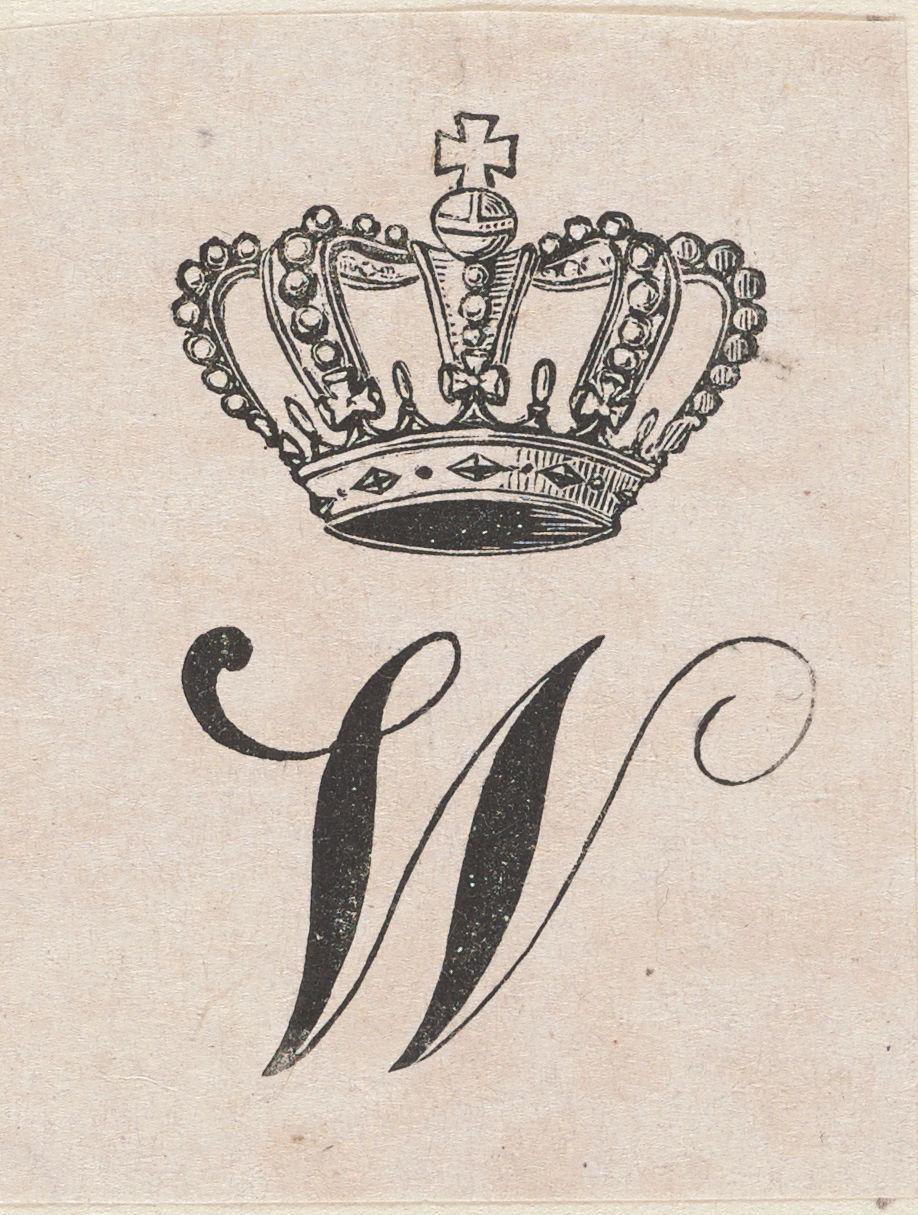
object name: print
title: Vignet met de letter W met een kroon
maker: isaac weissenbruch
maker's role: print maker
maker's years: 1826-1912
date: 1836-1912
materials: paper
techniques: engraving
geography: netherlands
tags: crown (symbol of sovereignty), fancy letters, vignette